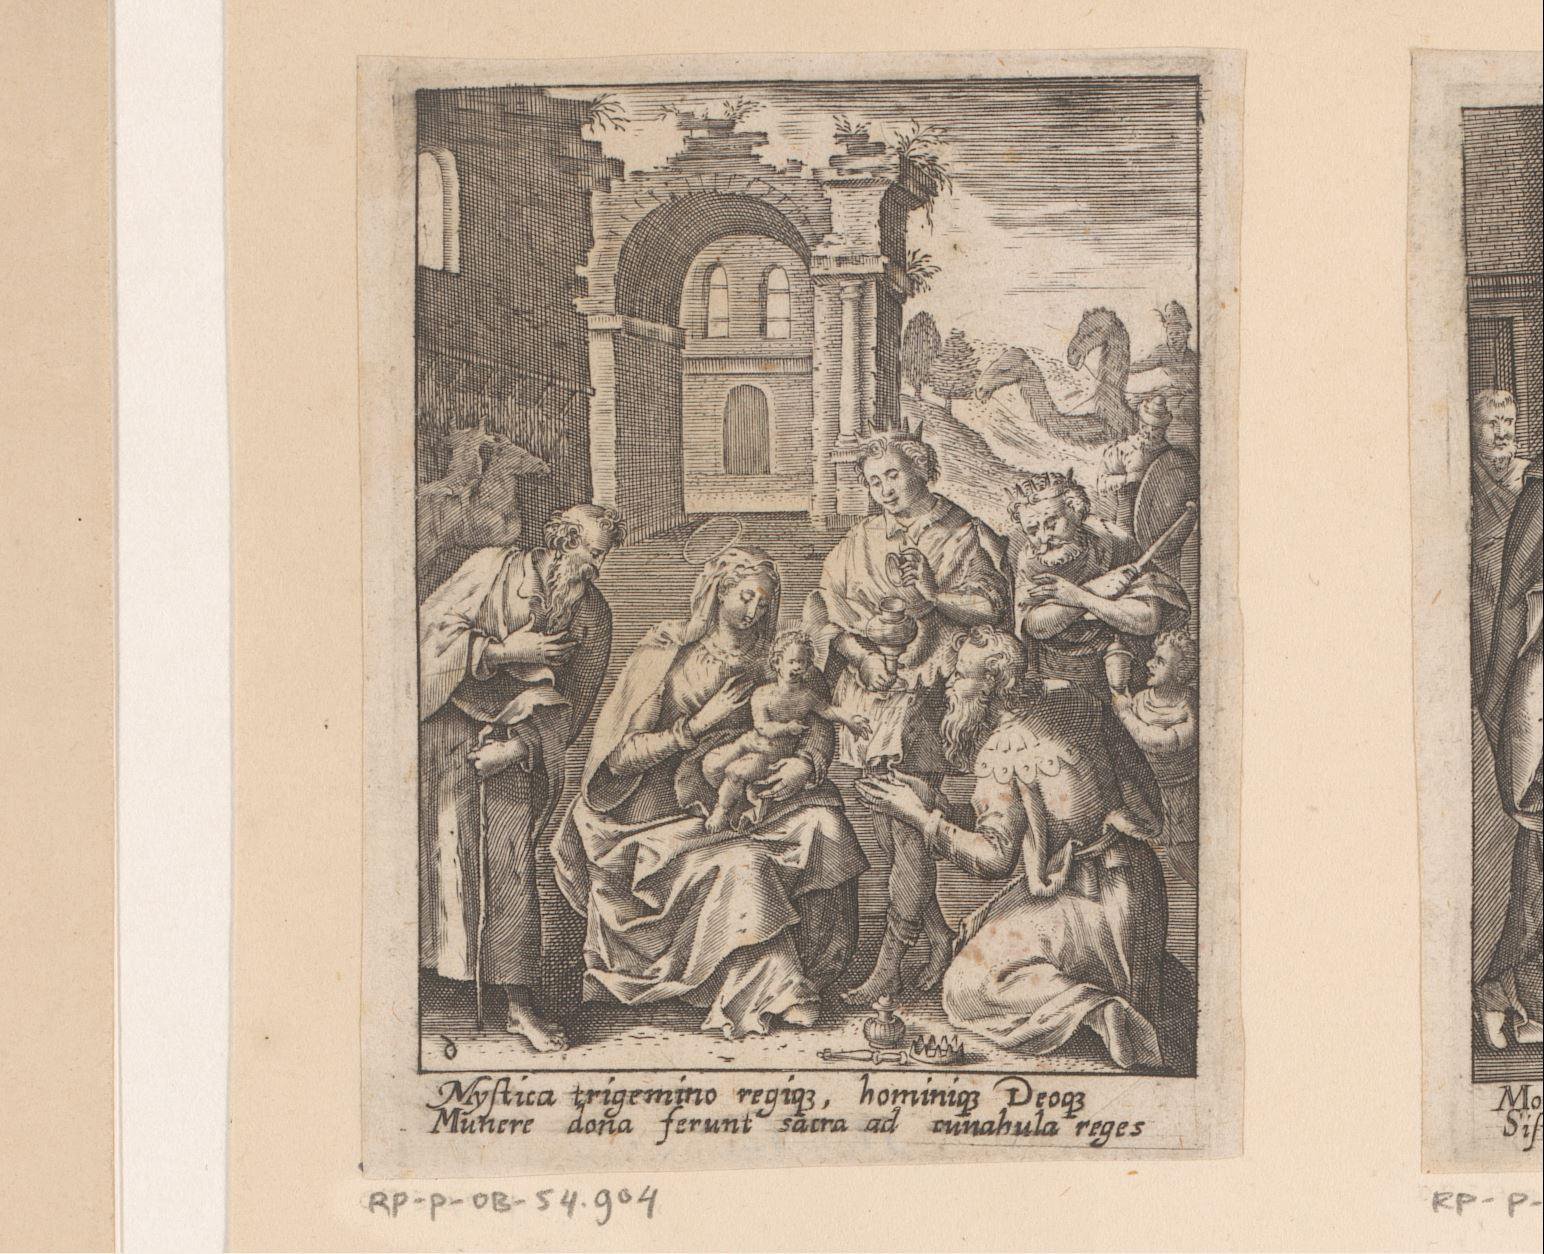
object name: print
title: Leven, passie en wederopstanding van Christus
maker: heinrich ulrich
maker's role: draughtsman, painter, print maker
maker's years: 1572-1671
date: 1582-1671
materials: paper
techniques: engraving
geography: germany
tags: adoration of the kings: the wise men present their gifts to the christ-child (gold, frankincense and myrrh)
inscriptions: number: ‘38. - 64.’, collector's mark: Lugt 240